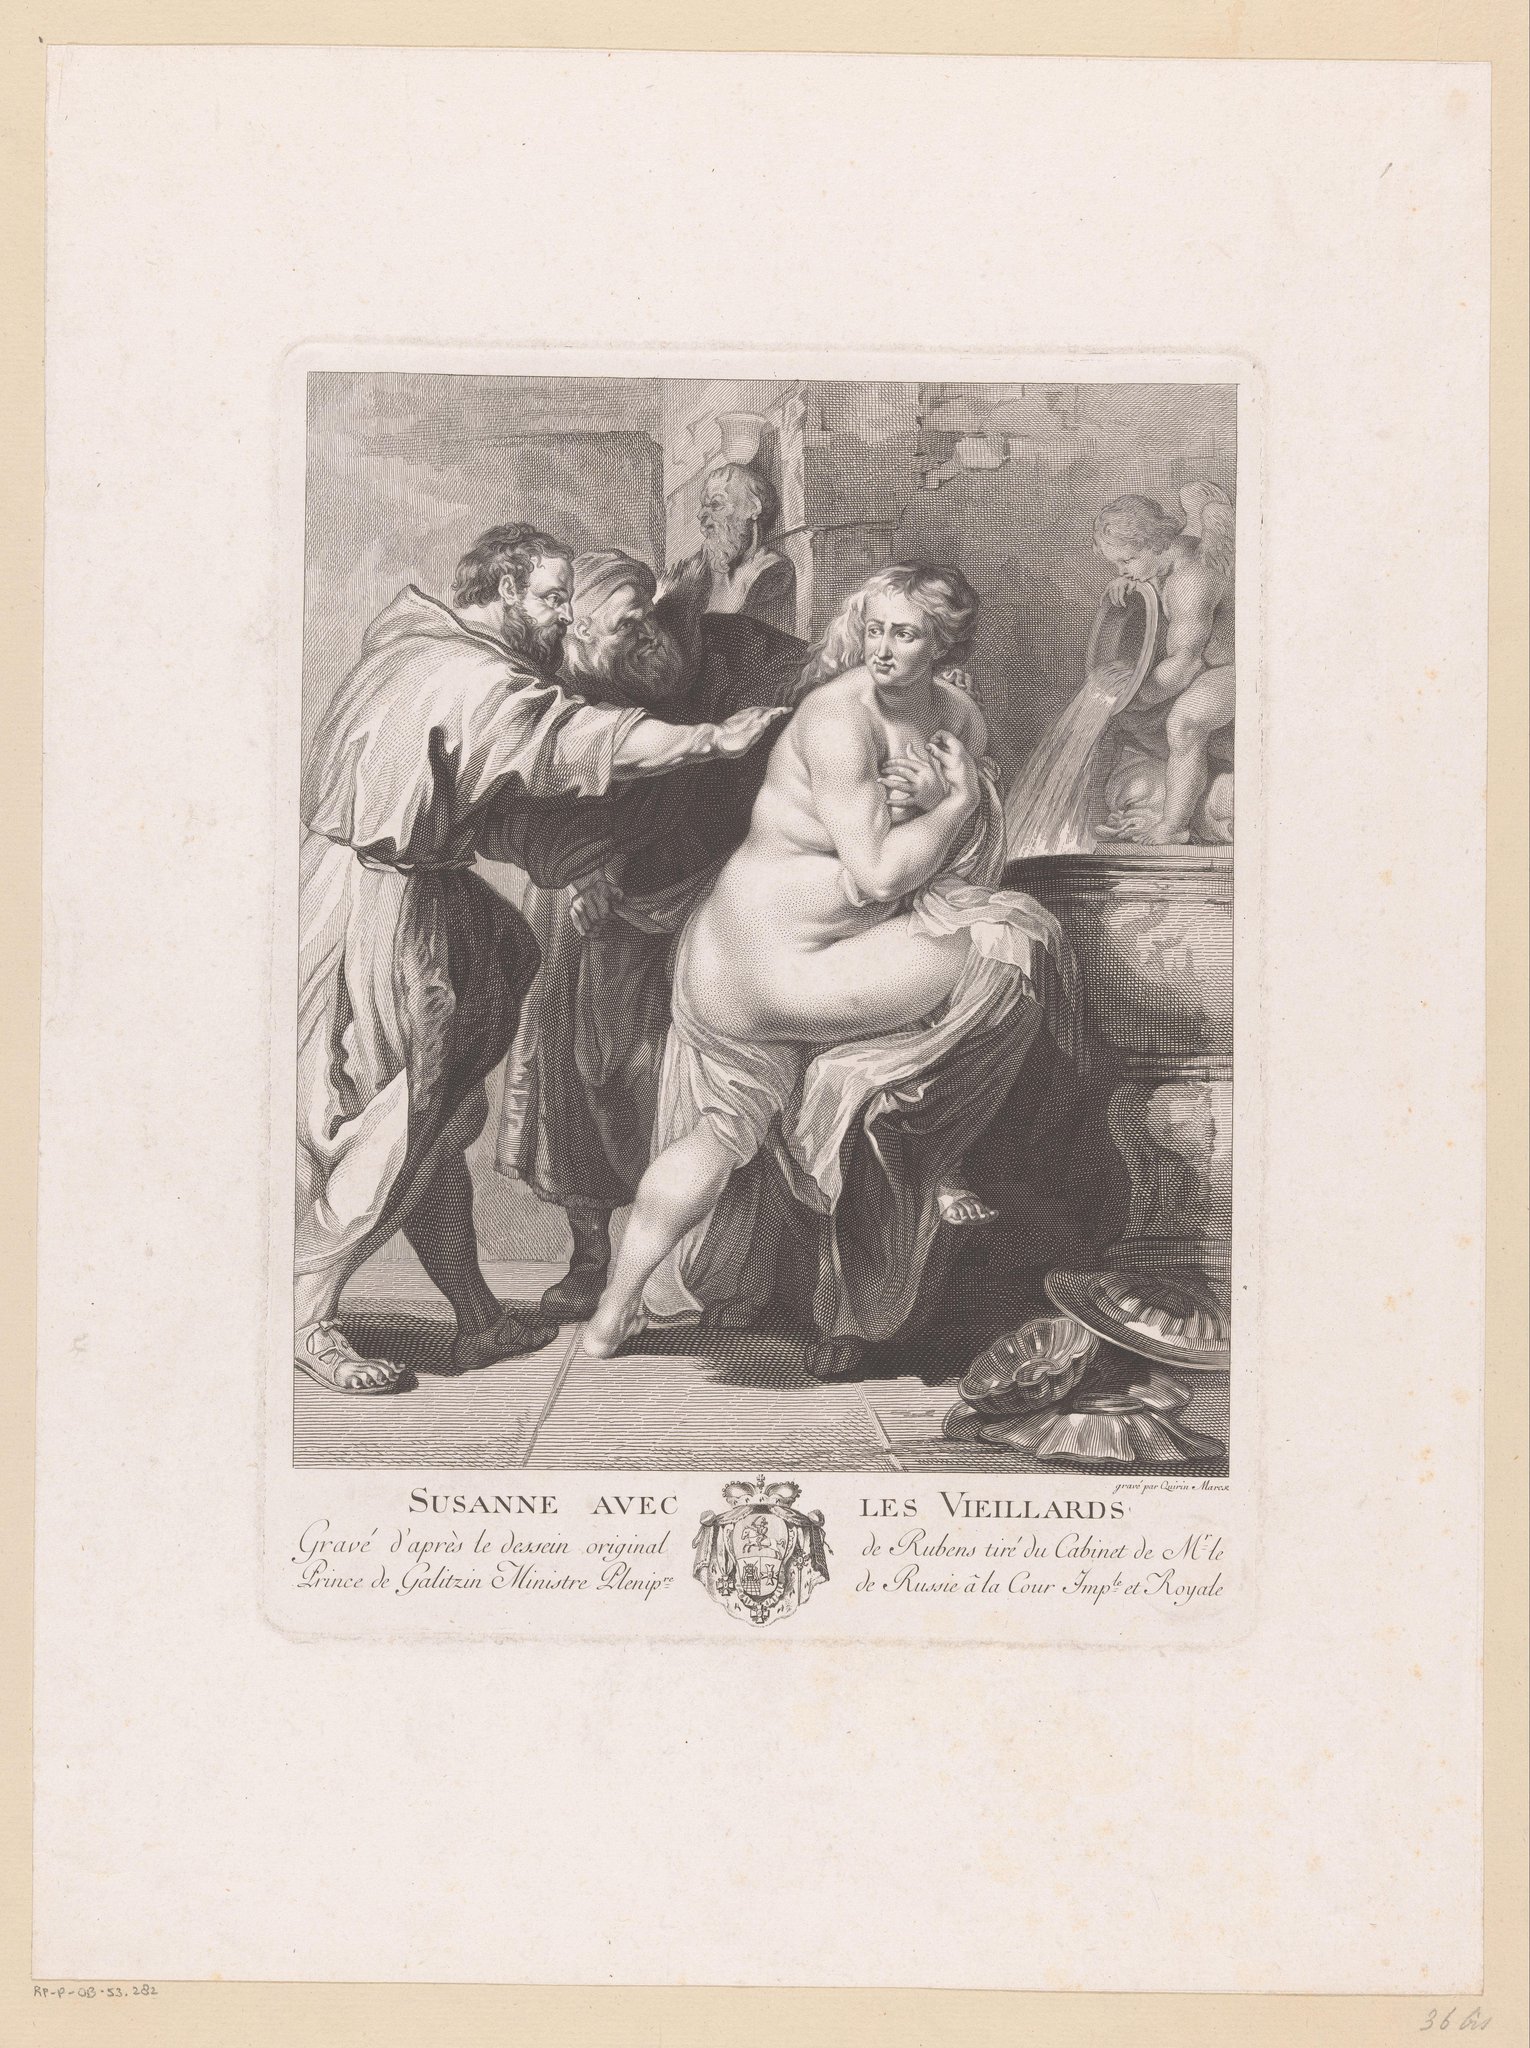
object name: print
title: Susanna en de ouderlingen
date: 1763-1811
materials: paper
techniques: engraving, etching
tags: the elders making advances towards susanna, armorial bearing, heraldry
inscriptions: collector's mark: Lugt 240